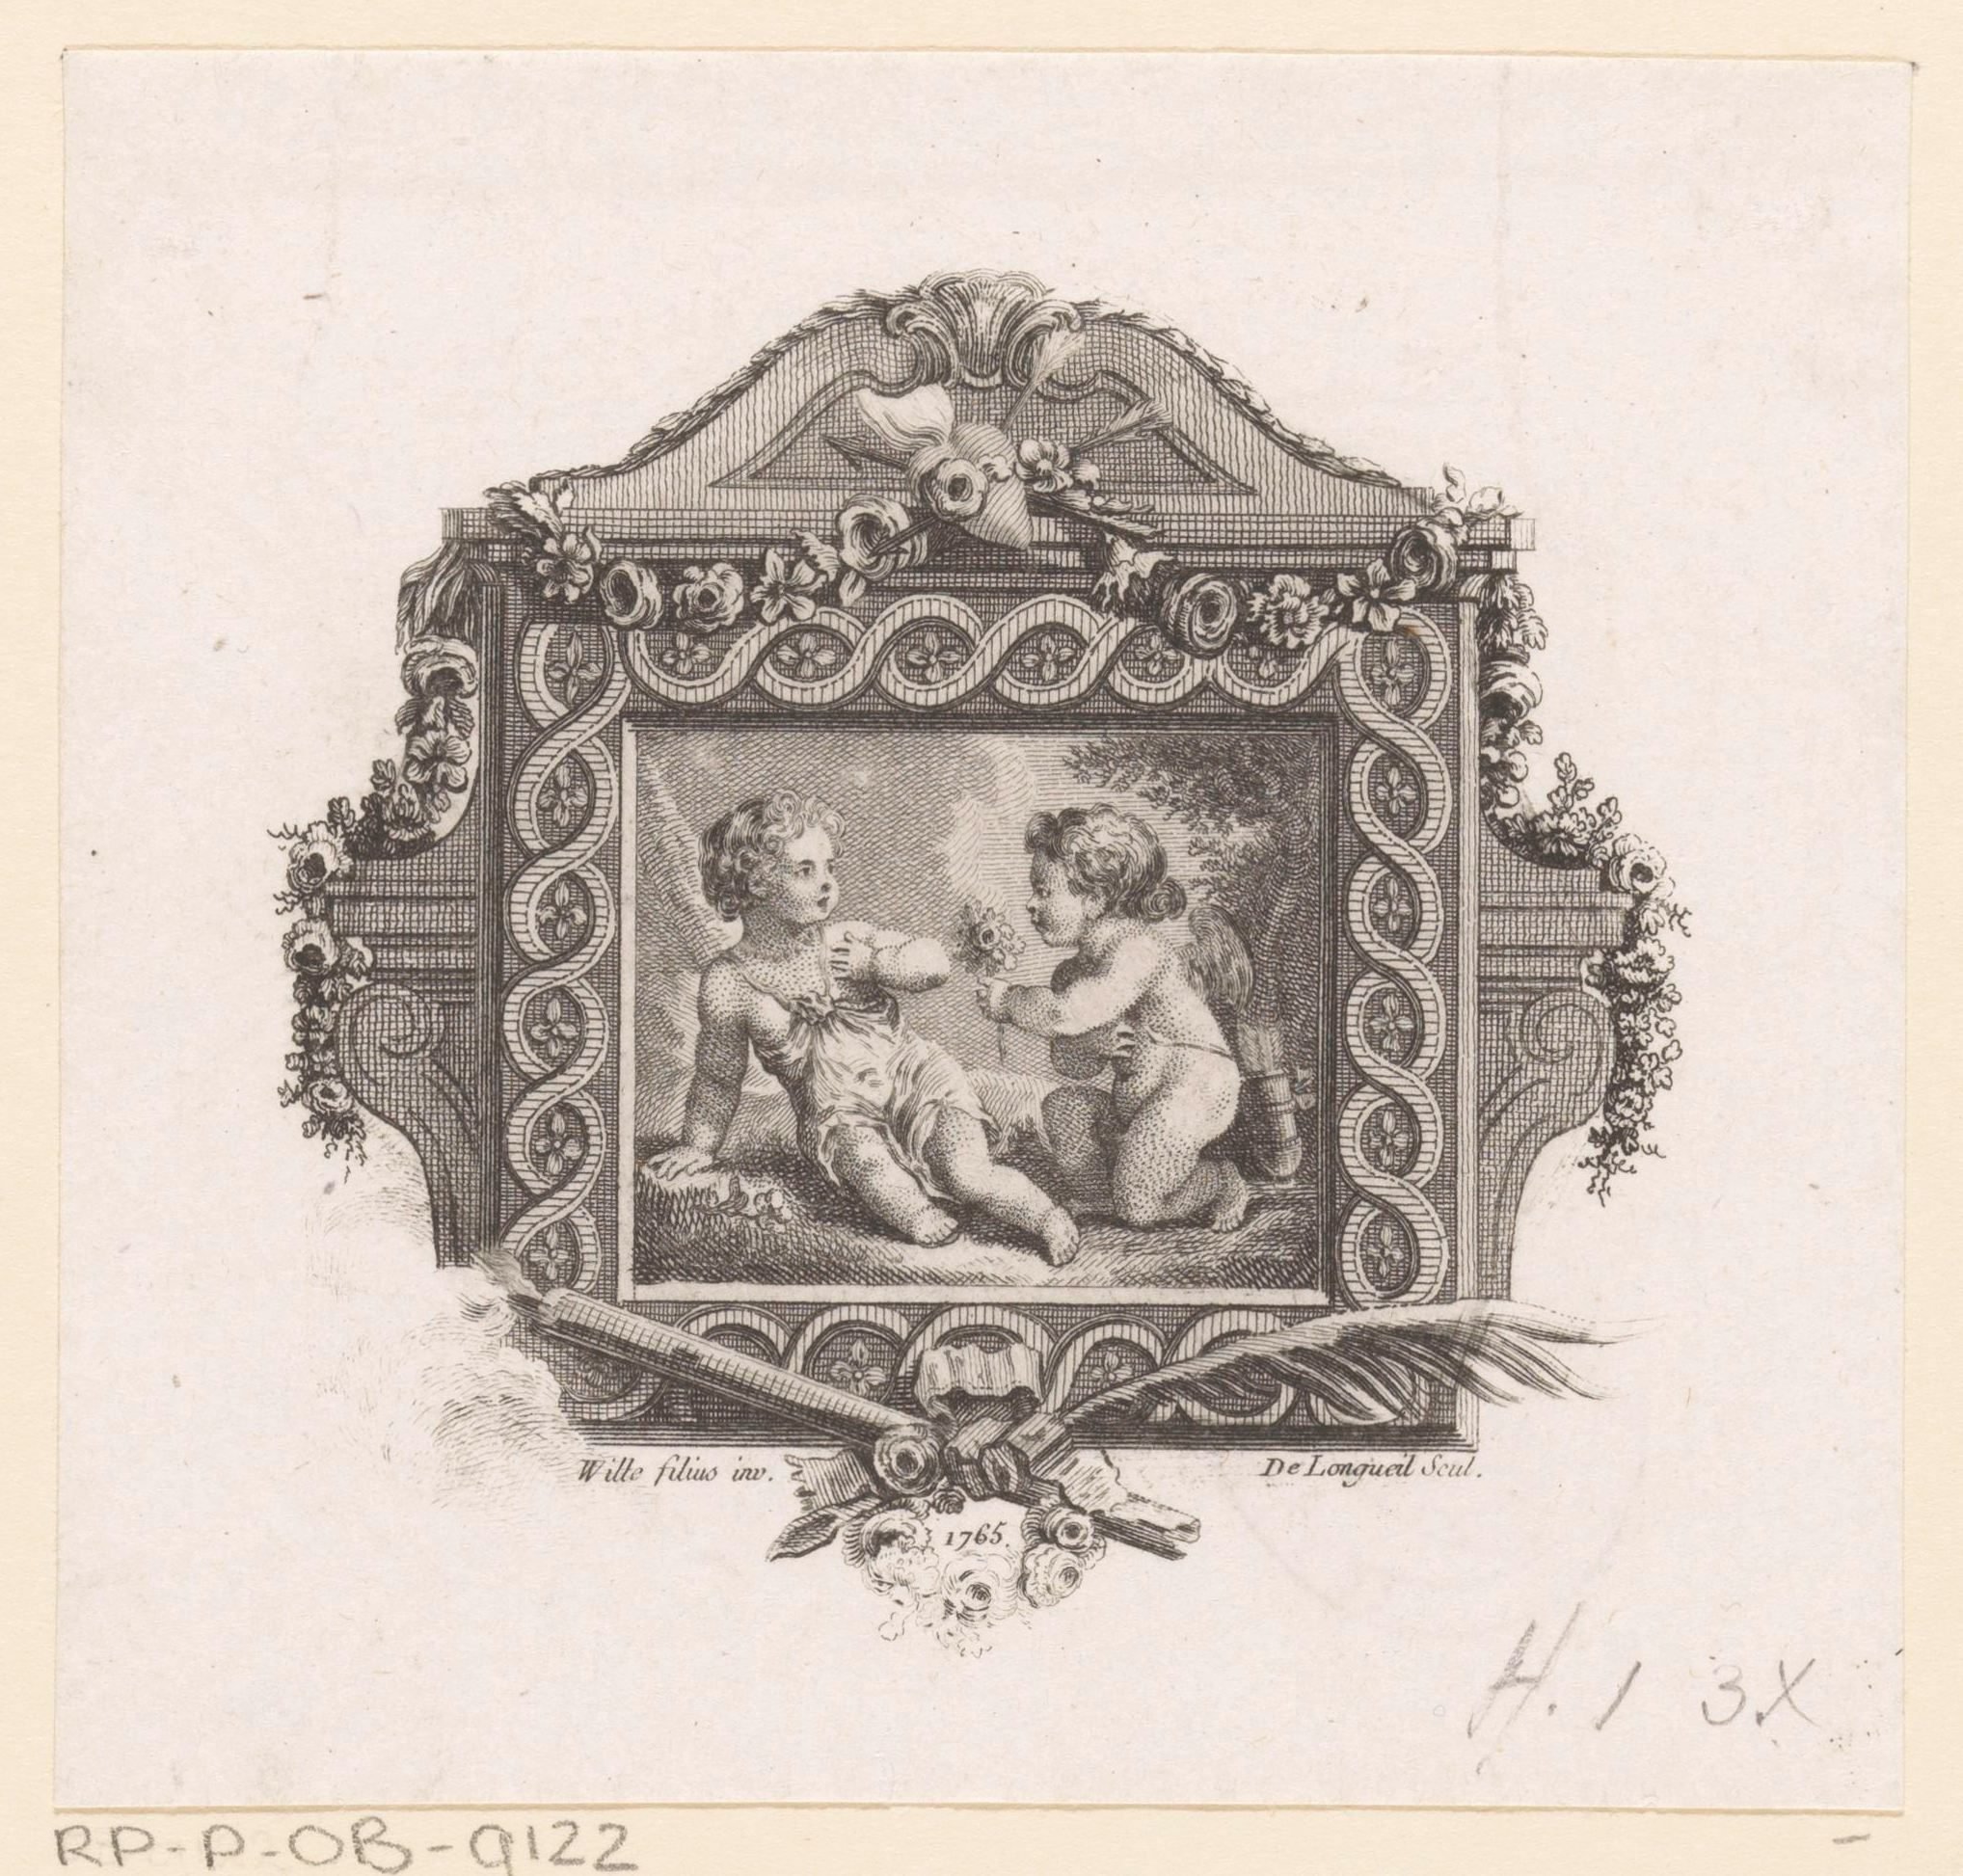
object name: ornament print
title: Vignet met putti met bloemen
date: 1765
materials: paper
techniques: etching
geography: france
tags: cut flowers; nosegay, bunch of flowers, vignette, cupids: 'amores', 'amoretti', 'putti'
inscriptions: collector's mark: Lugt 240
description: Een vignet met twee zittende putti. De putto rechts knielt en geeft bloemen aan de putto links. Zij beweegt verbaasd naar achter.